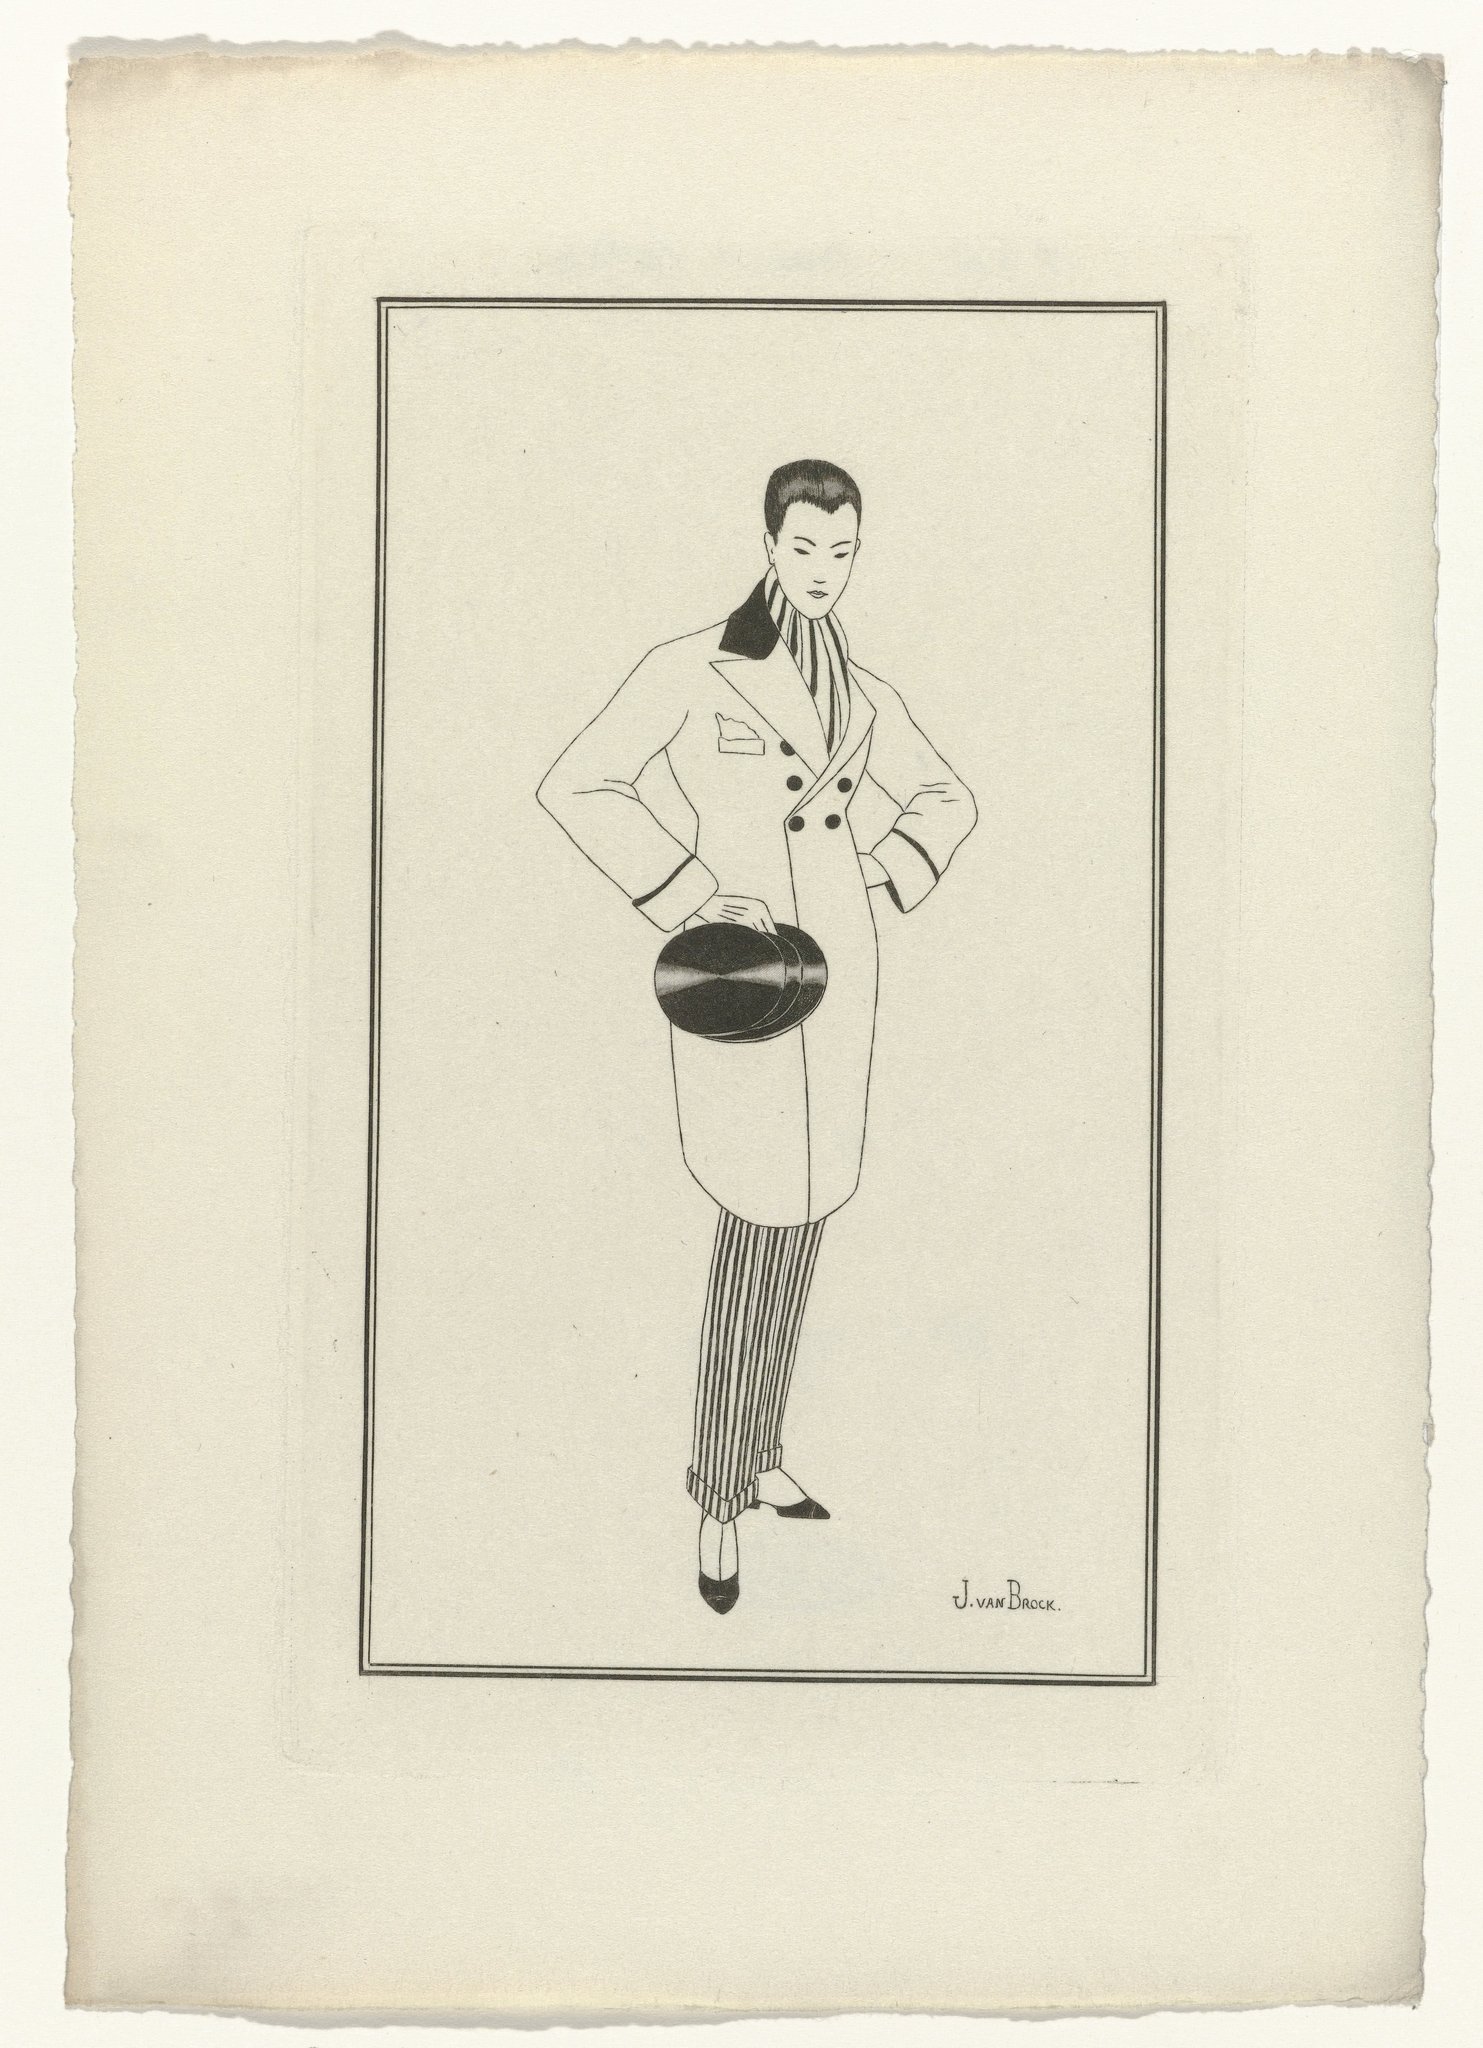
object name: fashion print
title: Journal des Dames et des Modes, Costumes Parisiens, 1914, No. 136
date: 1914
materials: paper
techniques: engraving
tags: trousers, breeches, etc. (pantalon) (+ men's clothes), coat: overcoat (+ men's clothes), fashion plates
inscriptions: caption: ‘Pardessus de vigogne bleu de France.’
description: Man gekleed in een pardessus van blauwe vigogne-wol op een gestreepte lange broek. Hoge hoed in de hand. Proefdruk van een prent uit het modetijdschrift Journal des Dames et des Modes (1912-1914).